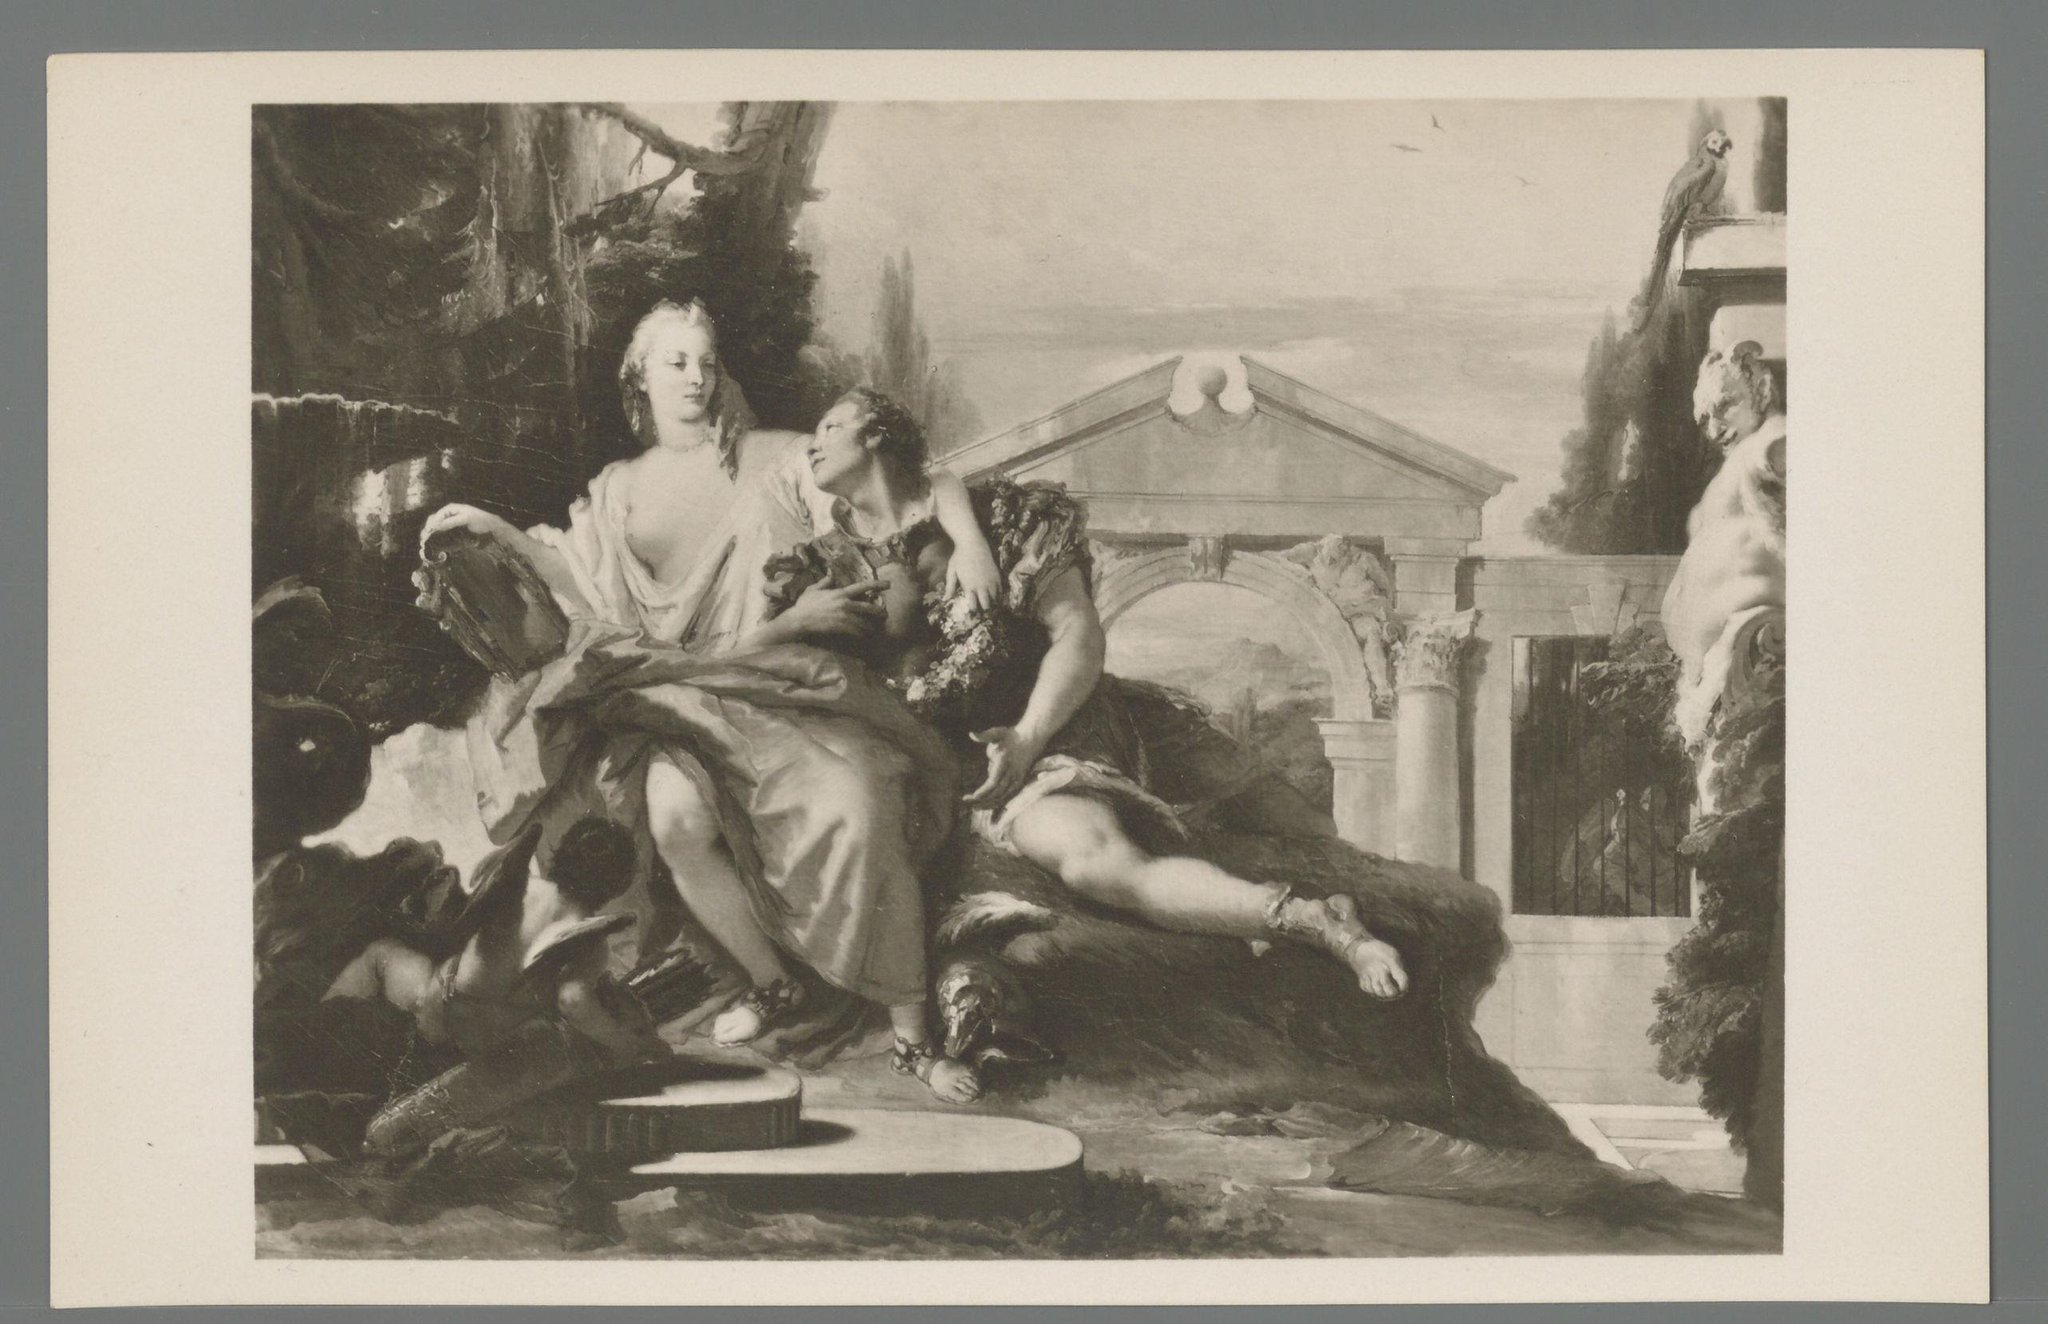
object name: ansichtkaart, prentbriefkaart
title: Rinaldo im Zauberbann Armidas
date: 1913-1930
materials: photographic support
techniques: photography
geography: munich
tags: garden, rinaldo, lovers' meeting